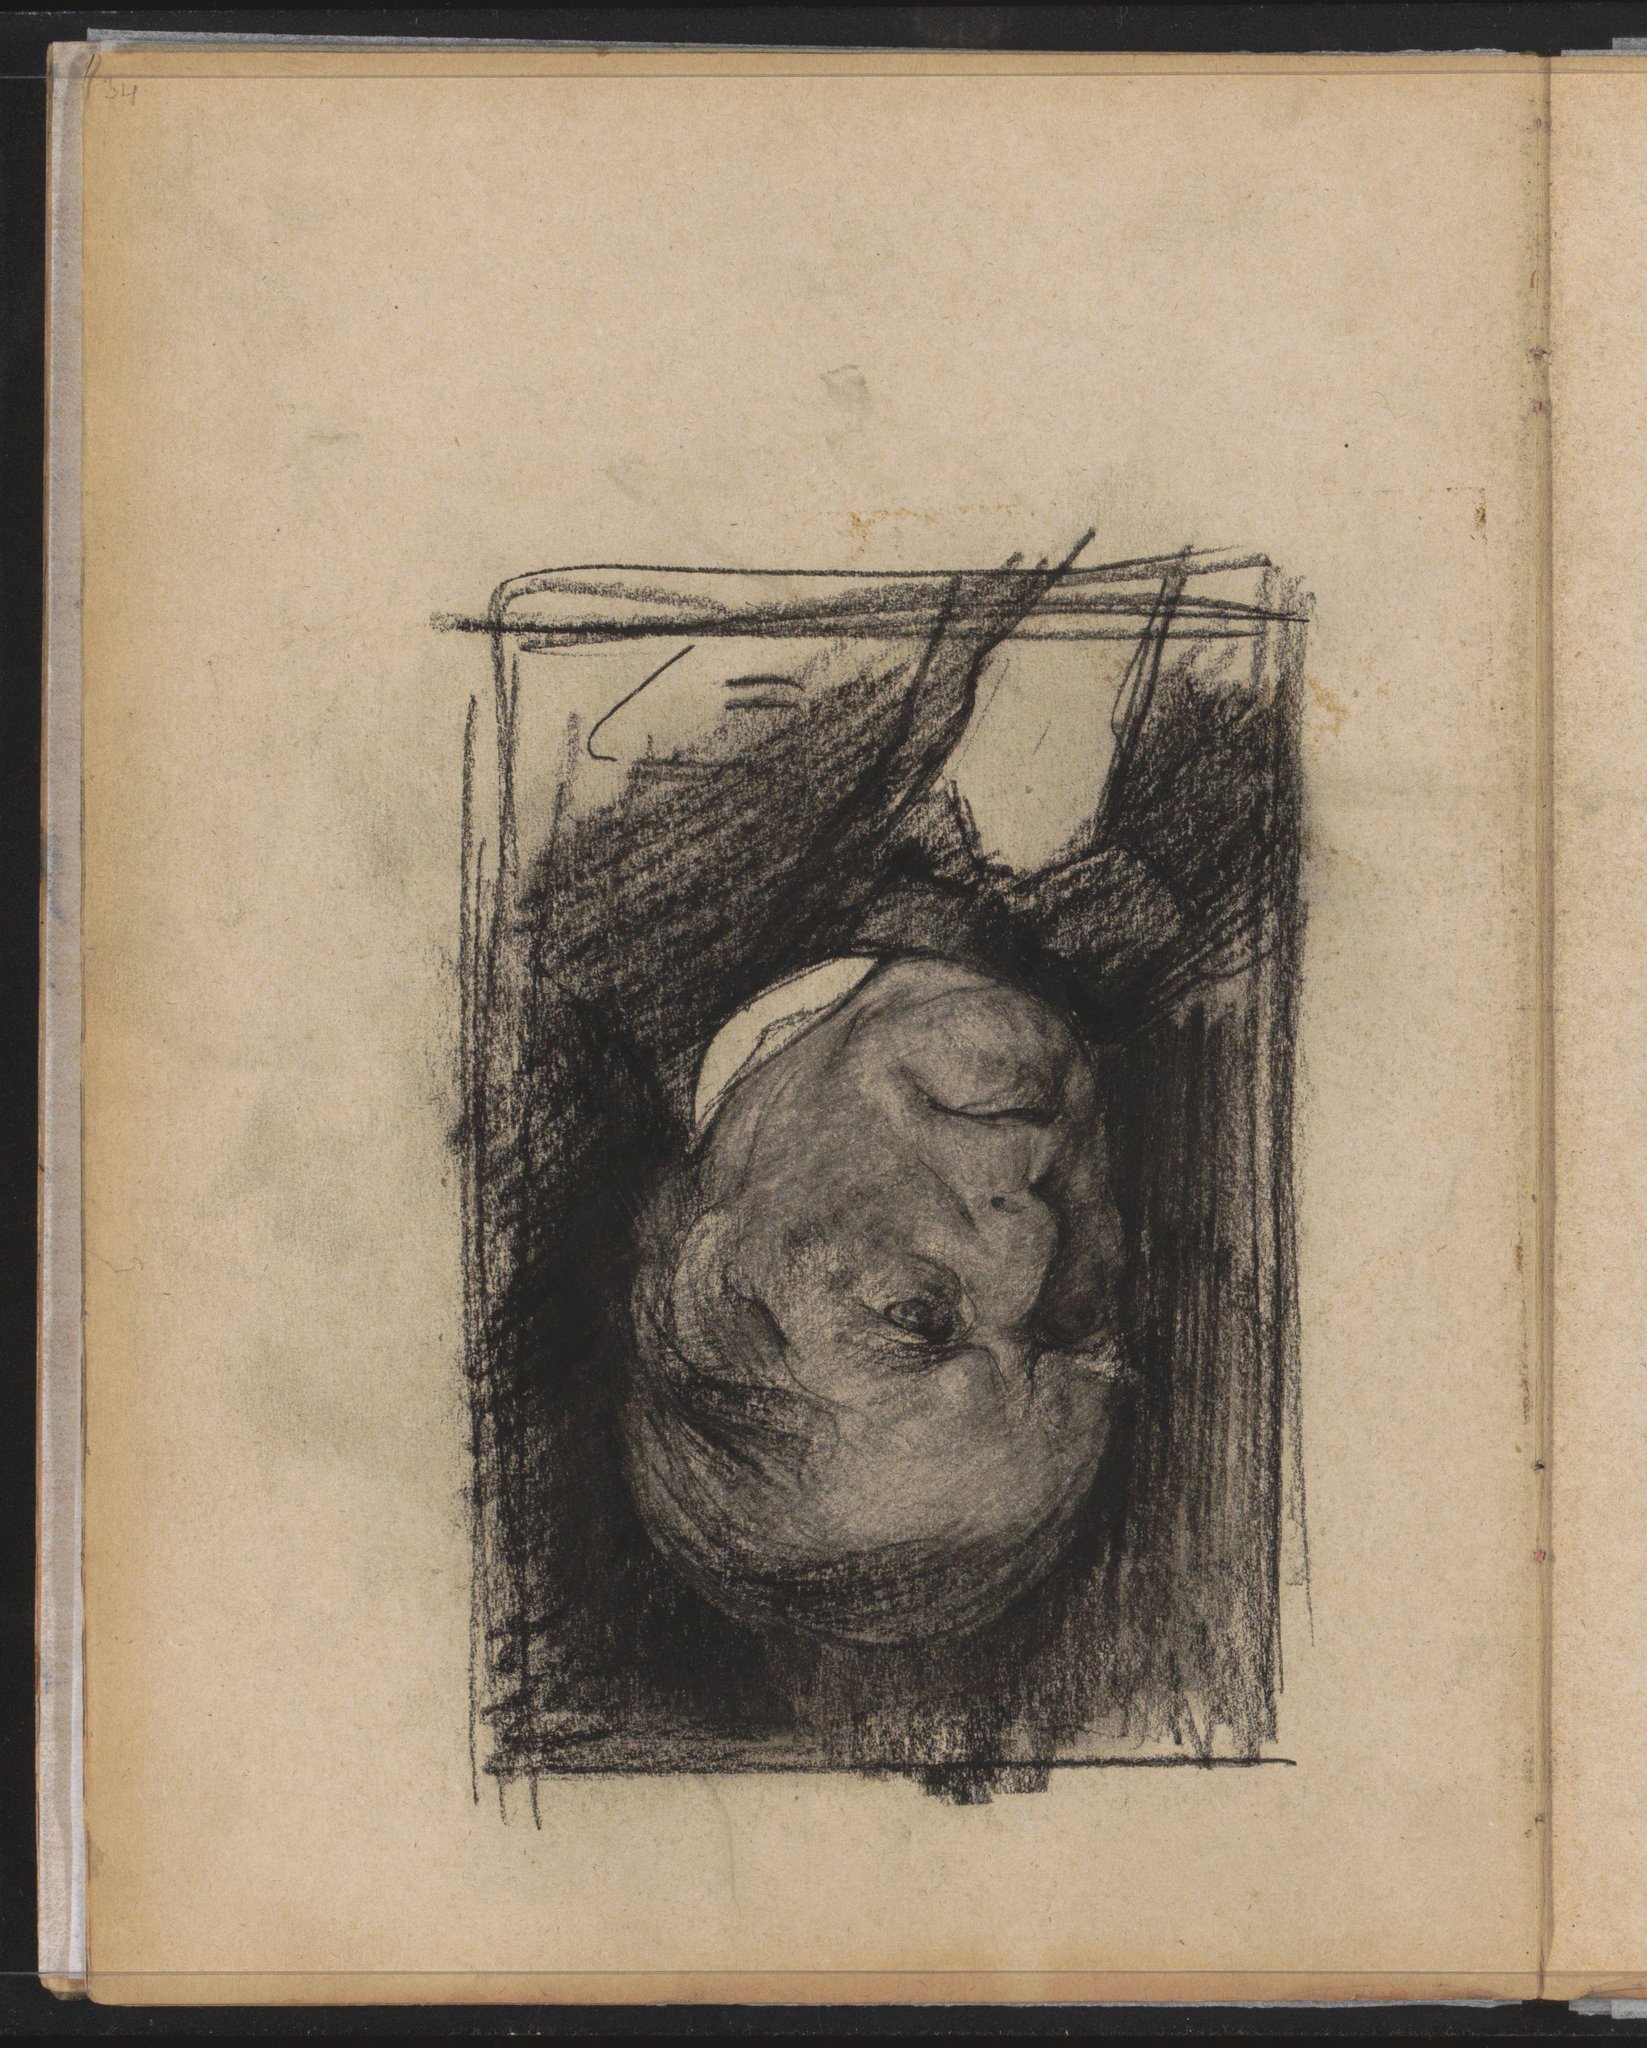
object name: sketchbook leaf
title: Portret van een onbekende man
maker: willem witsen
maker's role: draughtsman, painter, print maker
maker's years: 1860-1923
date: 1887-1891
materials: chalk, paper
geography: amsterdam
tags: anonymous historical person portrayed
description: Pagina 34 uit een schetsboek met 29 bladen.